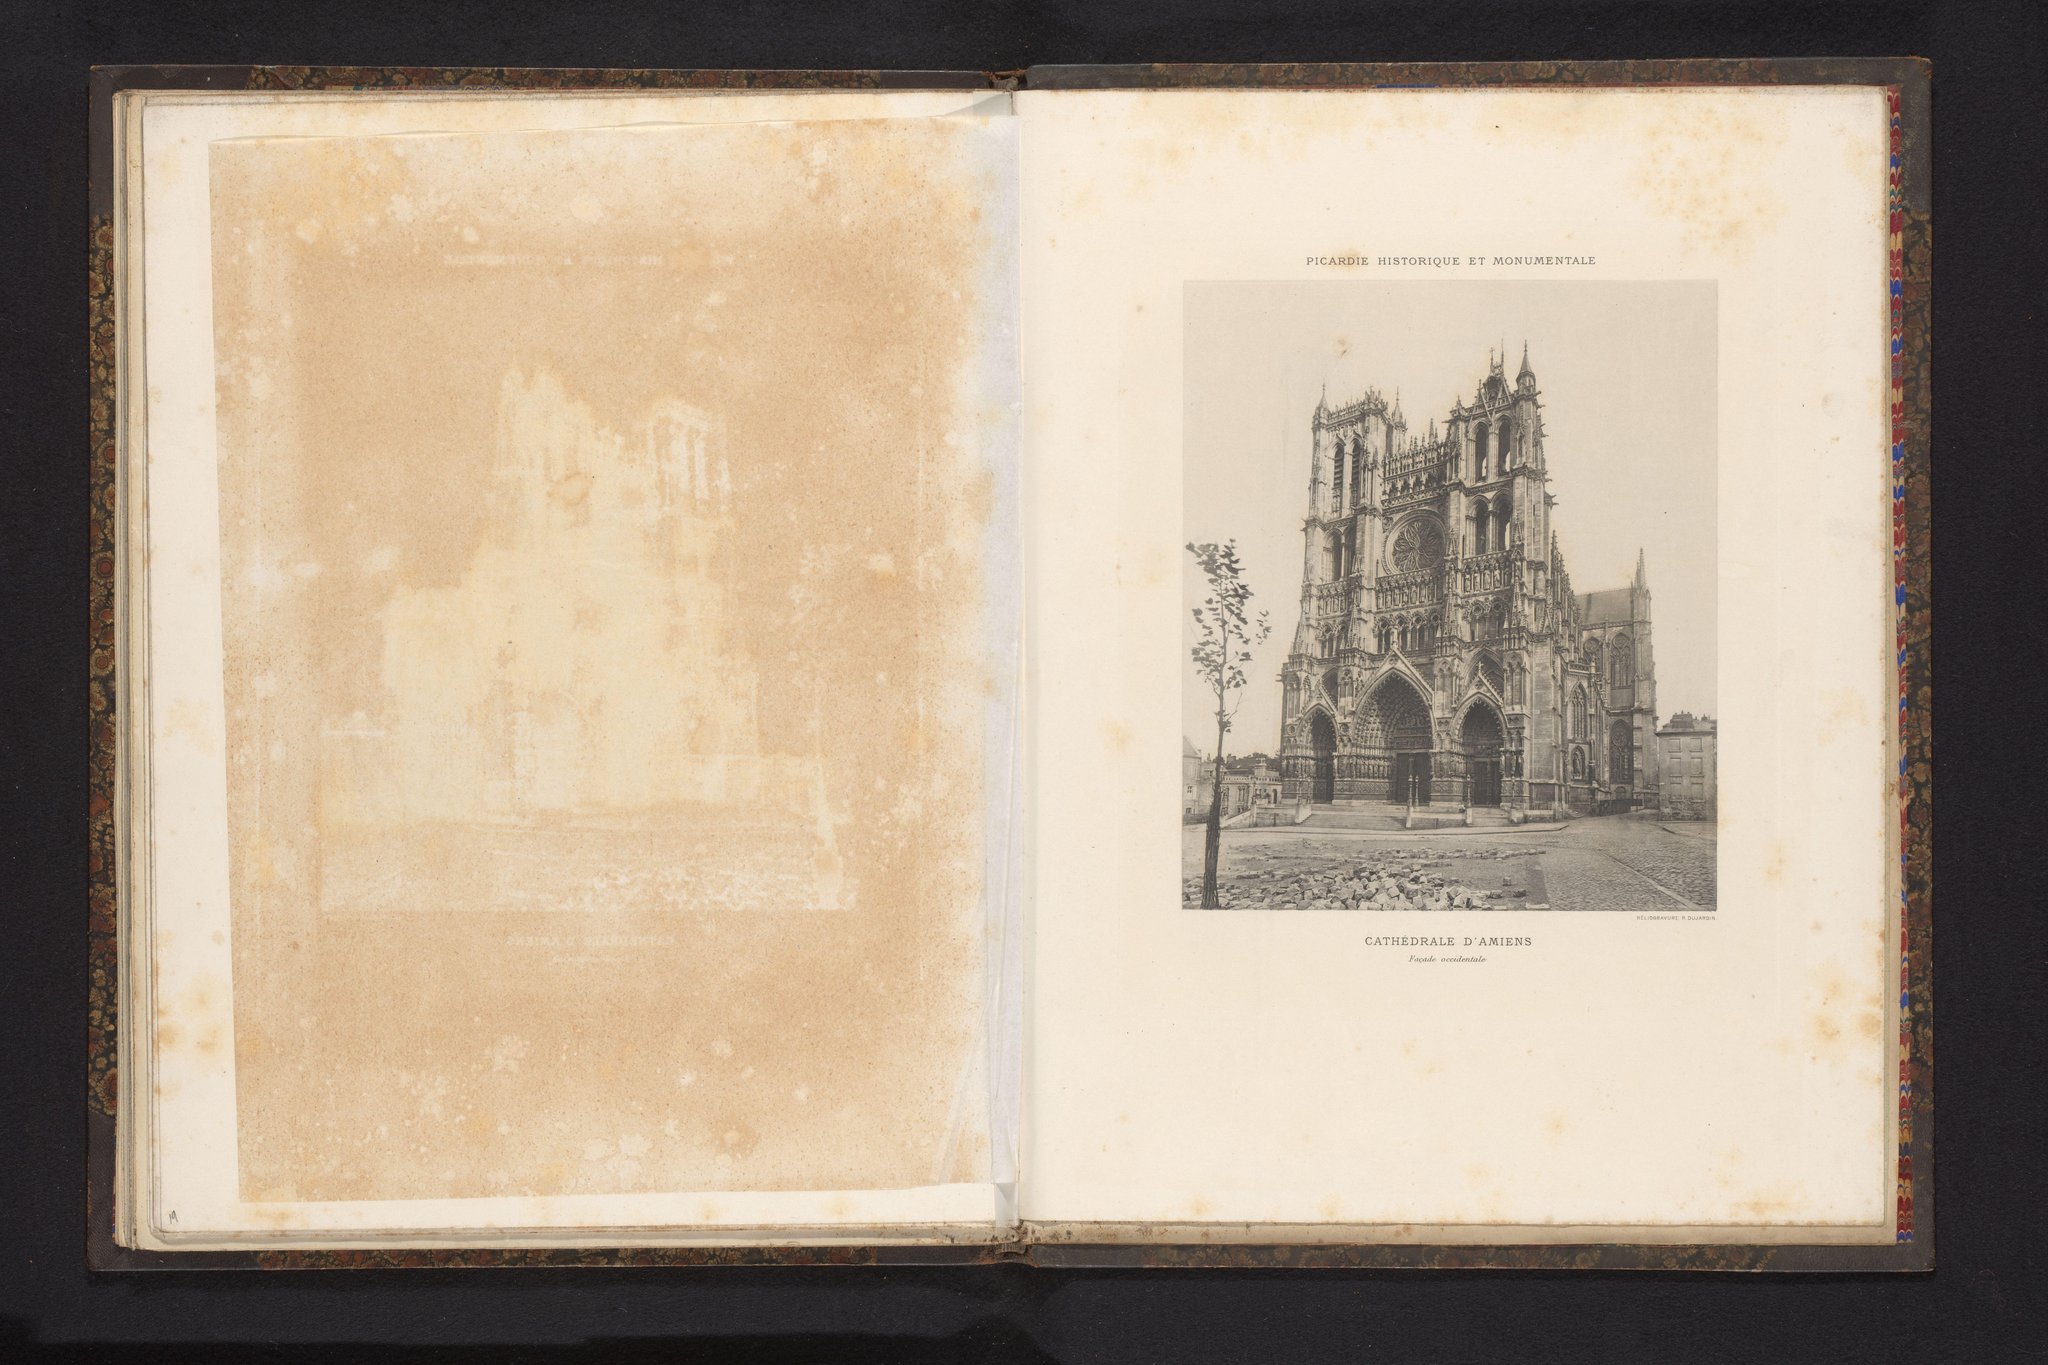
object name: photomechanical print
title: Gezicht op de Notre-Dame van Amiens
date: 1888-1893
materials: paper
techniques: photograph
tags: church (exterior), notre-dame d'amiens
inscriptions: inscription: ‘Cathédrale d'Amiens/ Faácade occidentale’